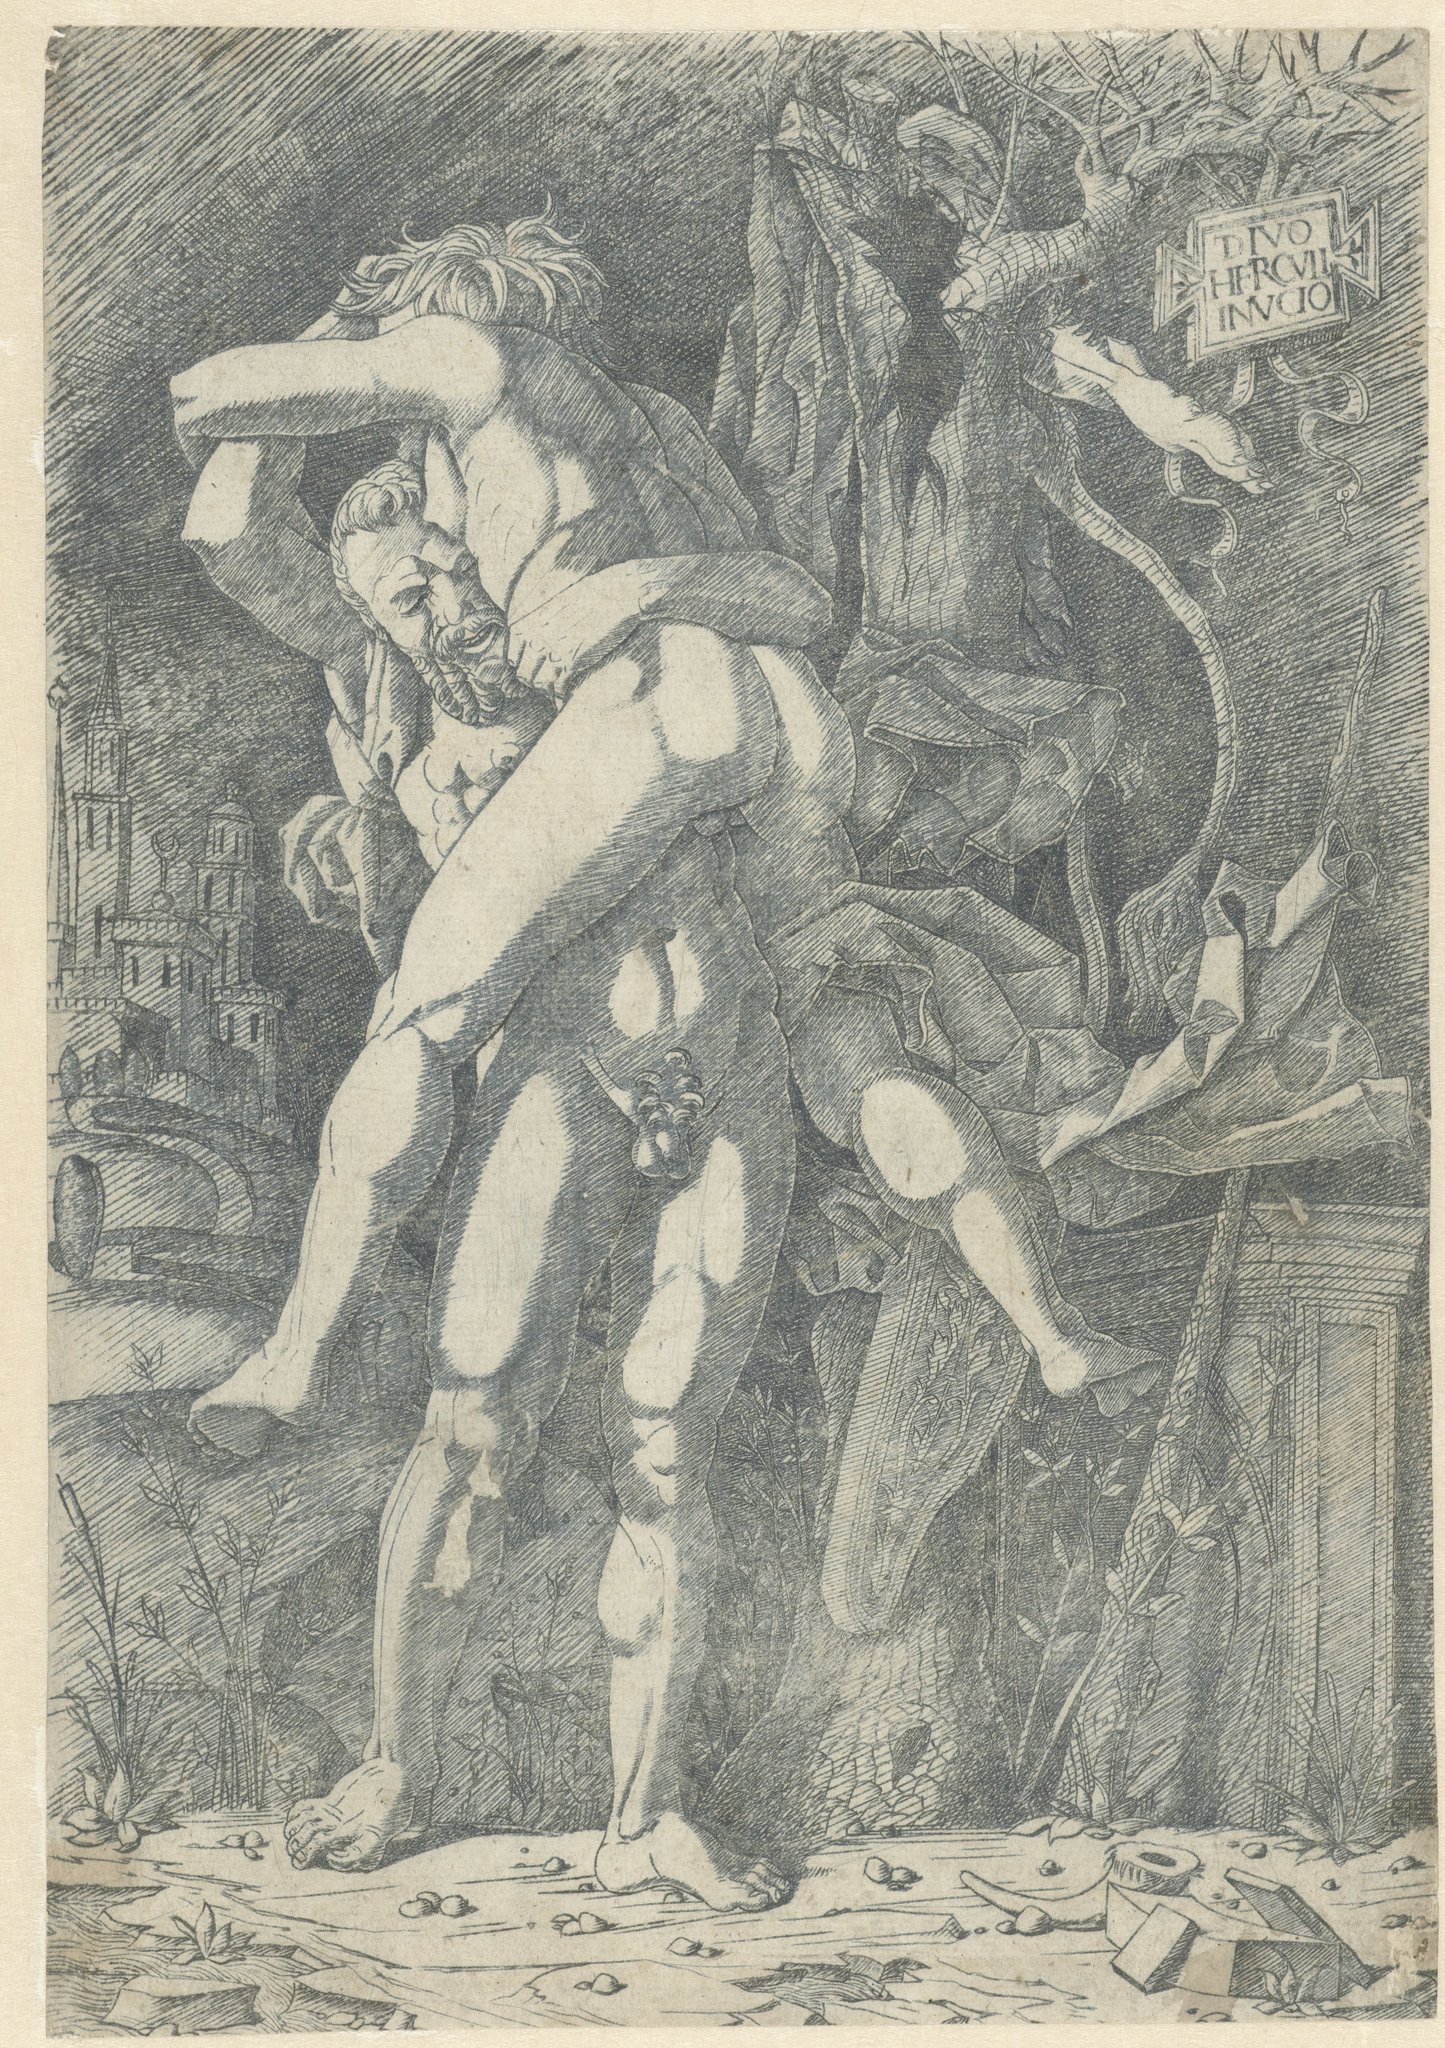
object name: print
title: Hercules and Antaeus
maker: nicoletto da modena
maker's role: print maker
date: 1490-1500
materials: paper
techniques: printing, engraving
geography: italy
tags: the giant antaeus is lifted in the air and crushed to death by hercules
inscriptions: collector's mark: Lugt 10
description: Renaissance artists often used the battle between the ancient hero Hercules and the giant Antheus to show athletic figures locked in complex wrestling holds. Three different engravers made prints based on Andrea Mantegna’s Hercules and Antaeus. An impression in blue ink is especially rare.